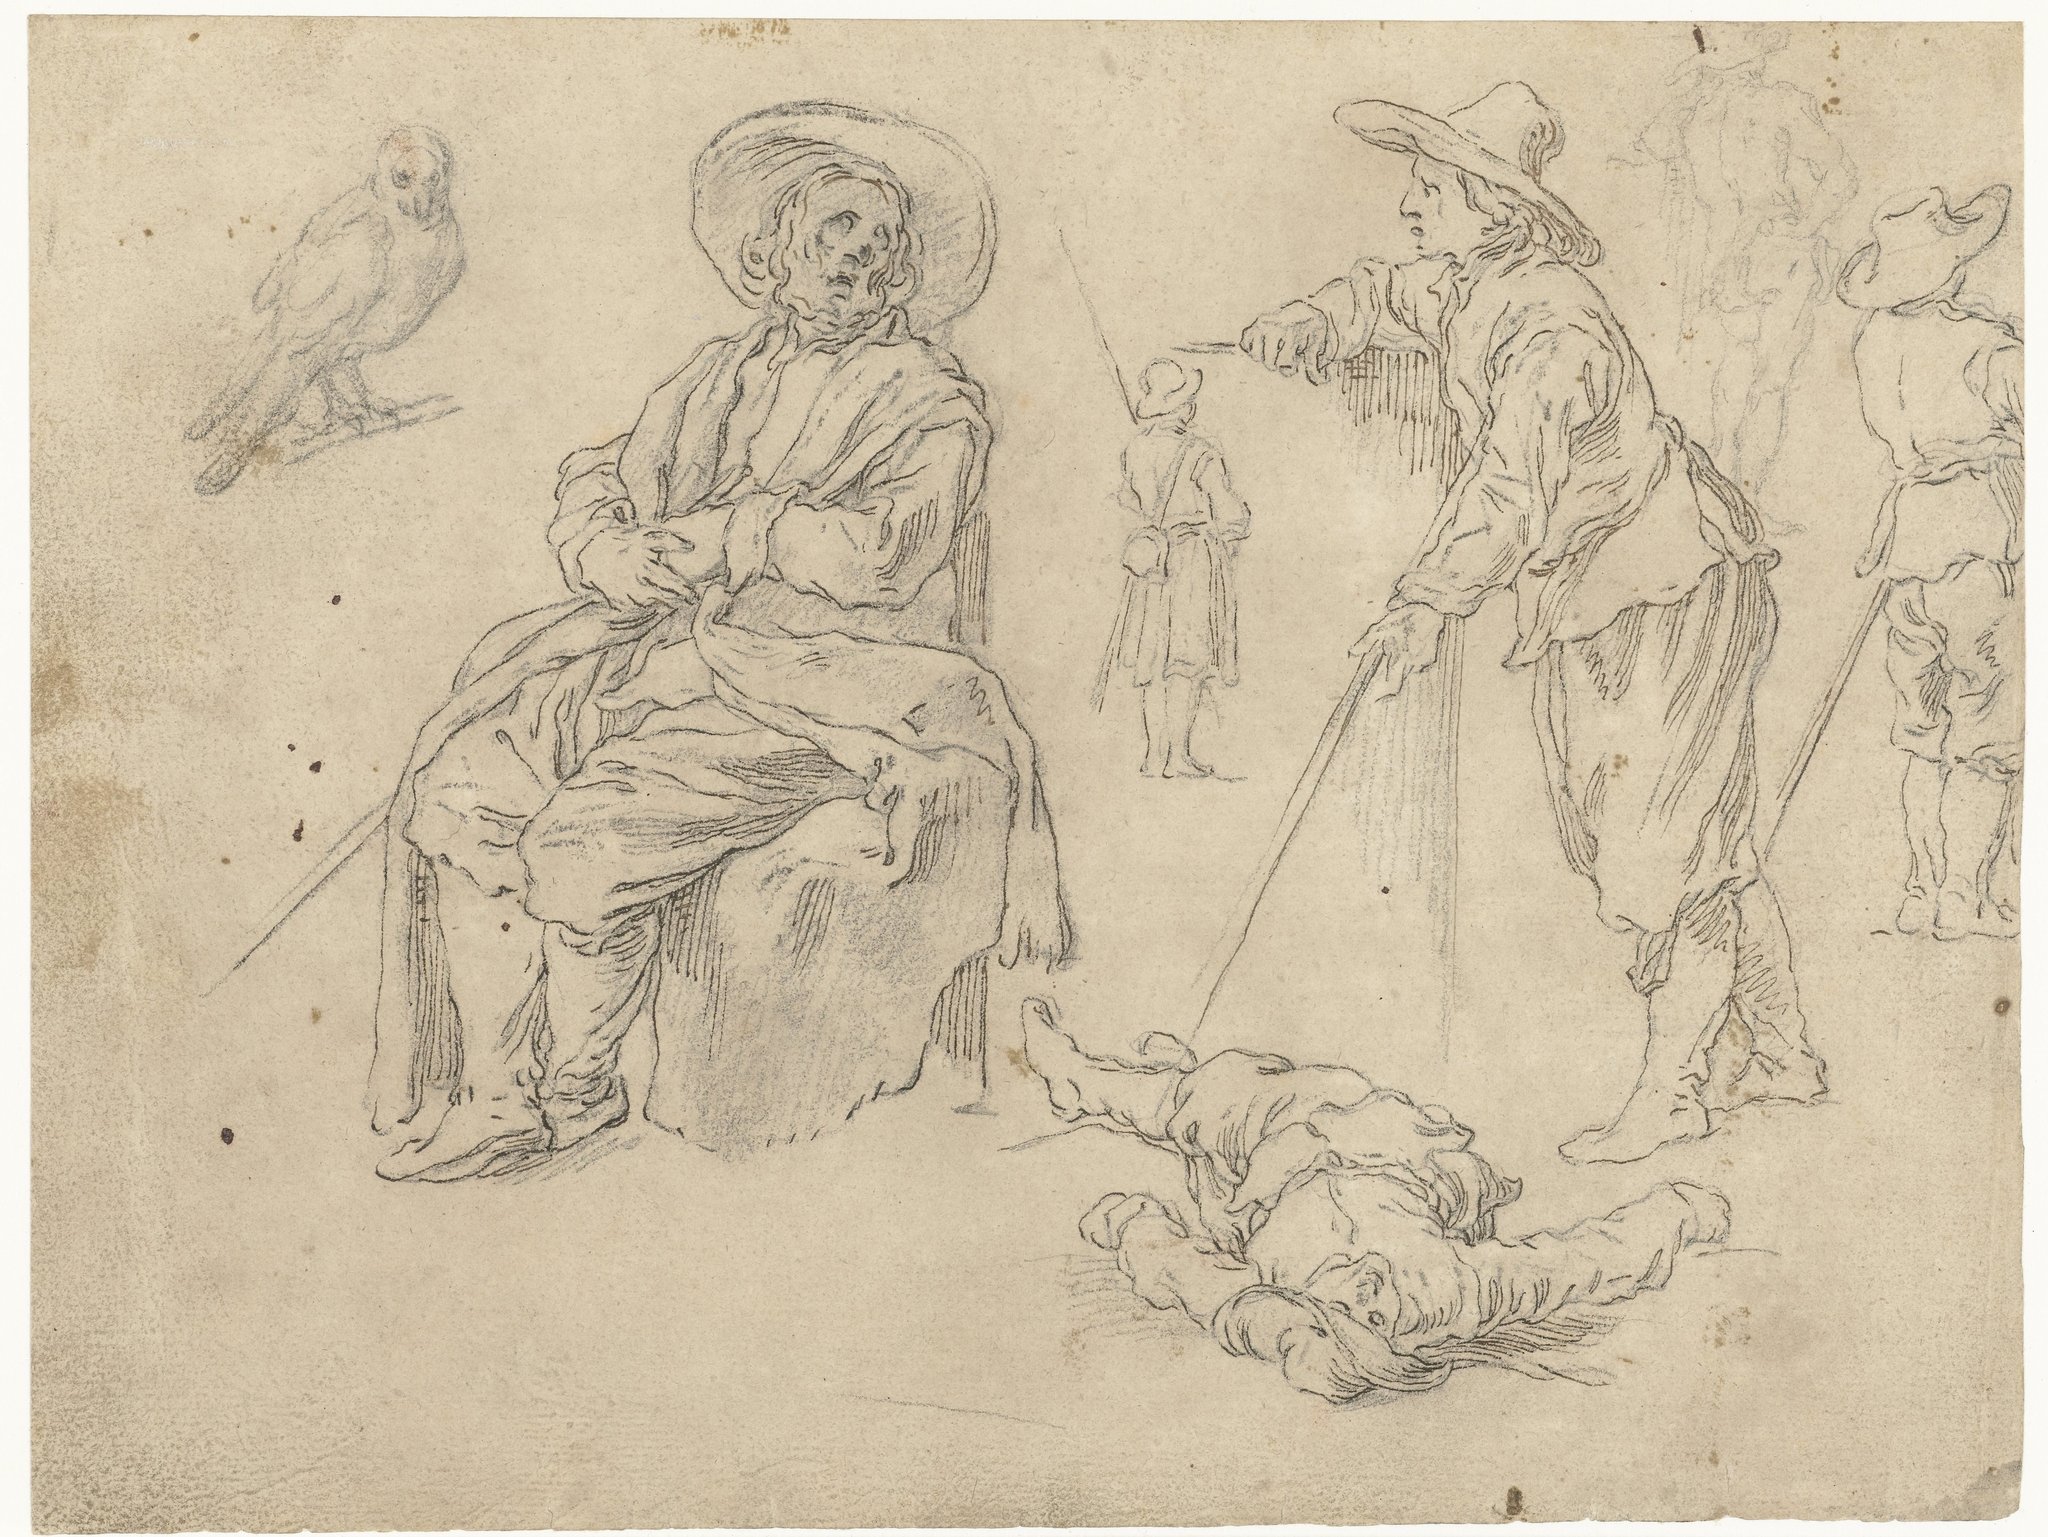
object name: drawing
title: Zittende oude man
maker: abraham bloemaert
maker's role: draughtsman, painter, print maker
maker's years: 1566-1651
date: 1625-1629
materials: chalk, ink, paper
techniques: pen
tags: standing figure, sitting figure, lying figure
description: Afkomstig uit een schetsboek van 43 (?) bladen.